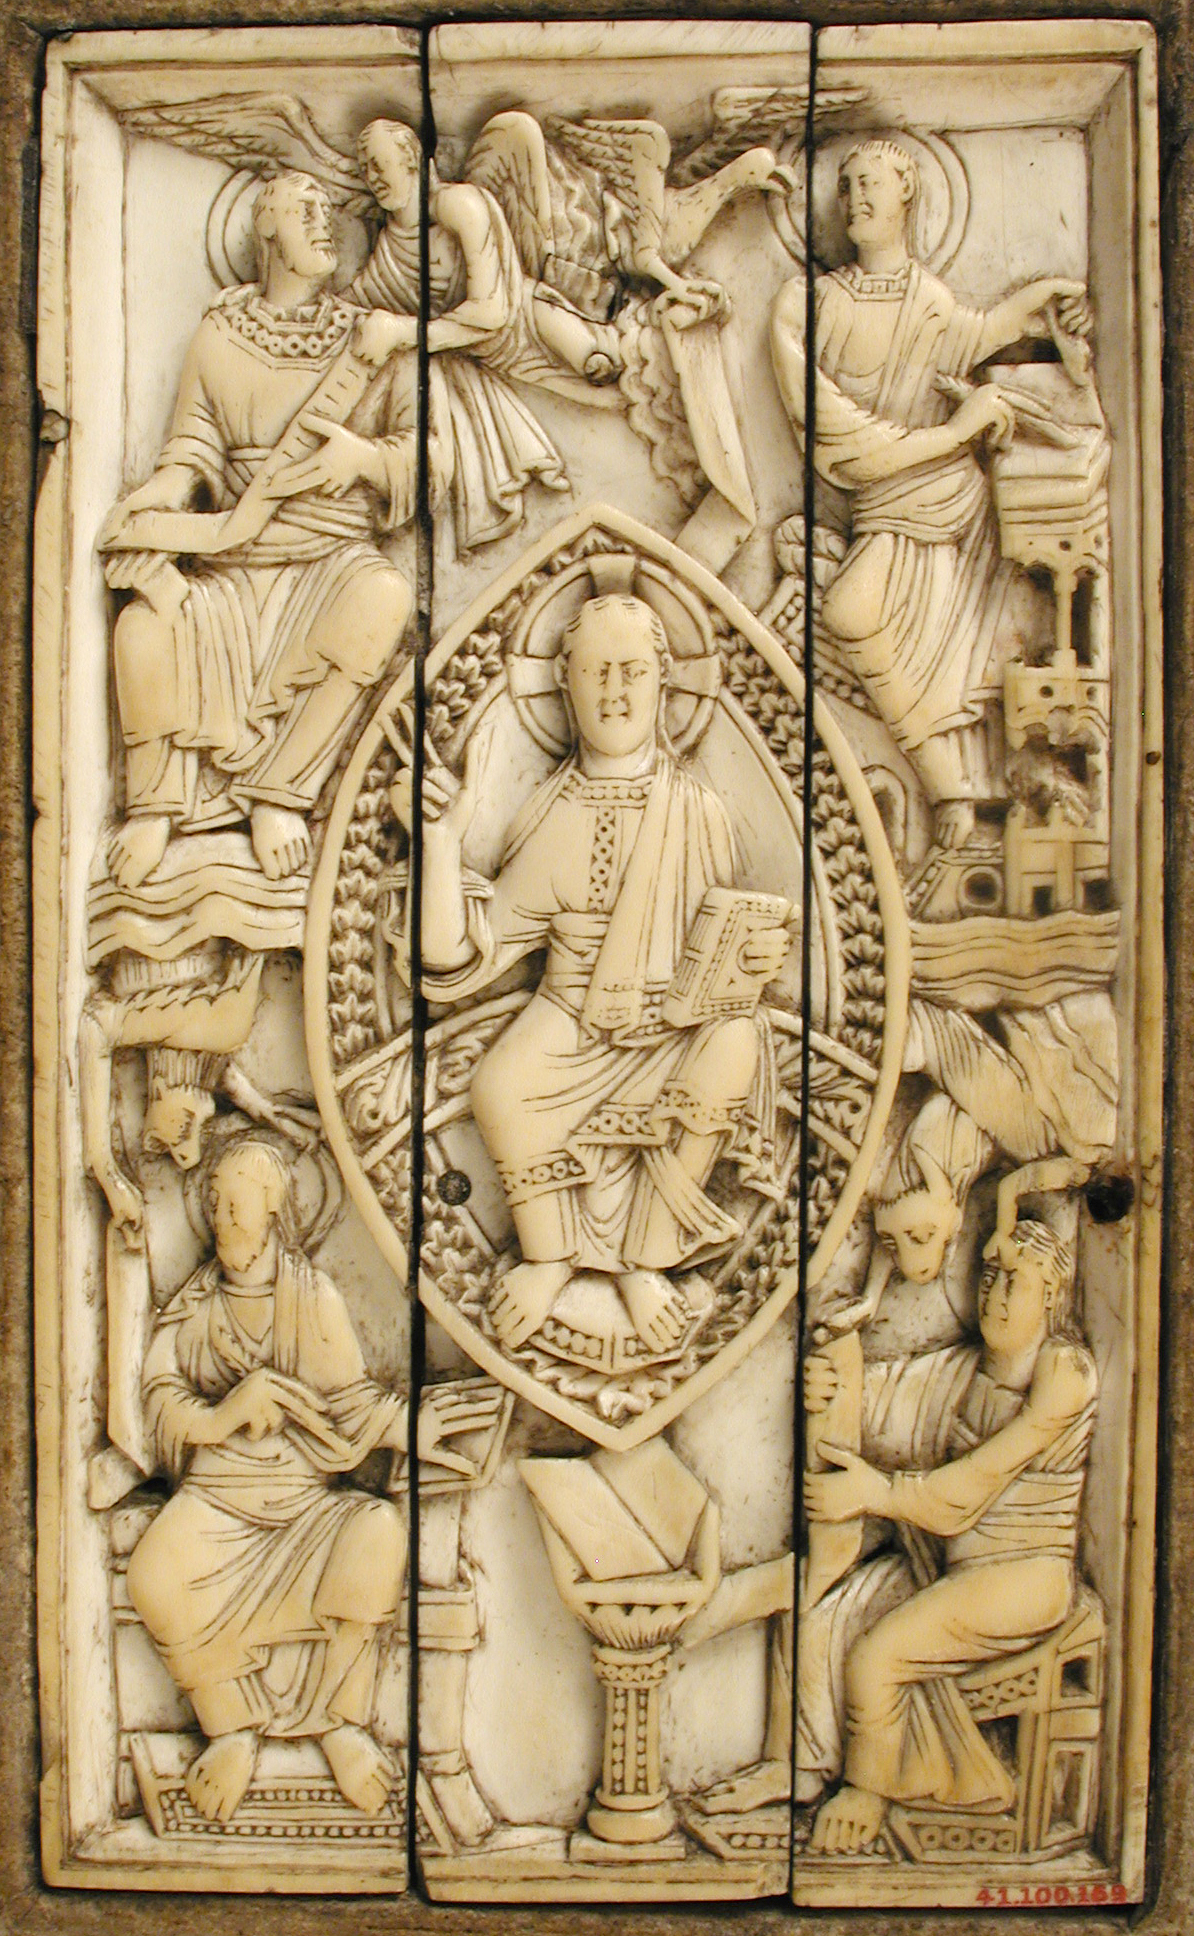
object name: book cover plaque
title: Plaque with Christ in Majesty and the Four Evangelists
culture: ottonian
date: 1001-1100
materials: ivory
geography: germany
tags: eagles,angels,christ,saint john the evangelist,saint mark,saint matthew,evangelists